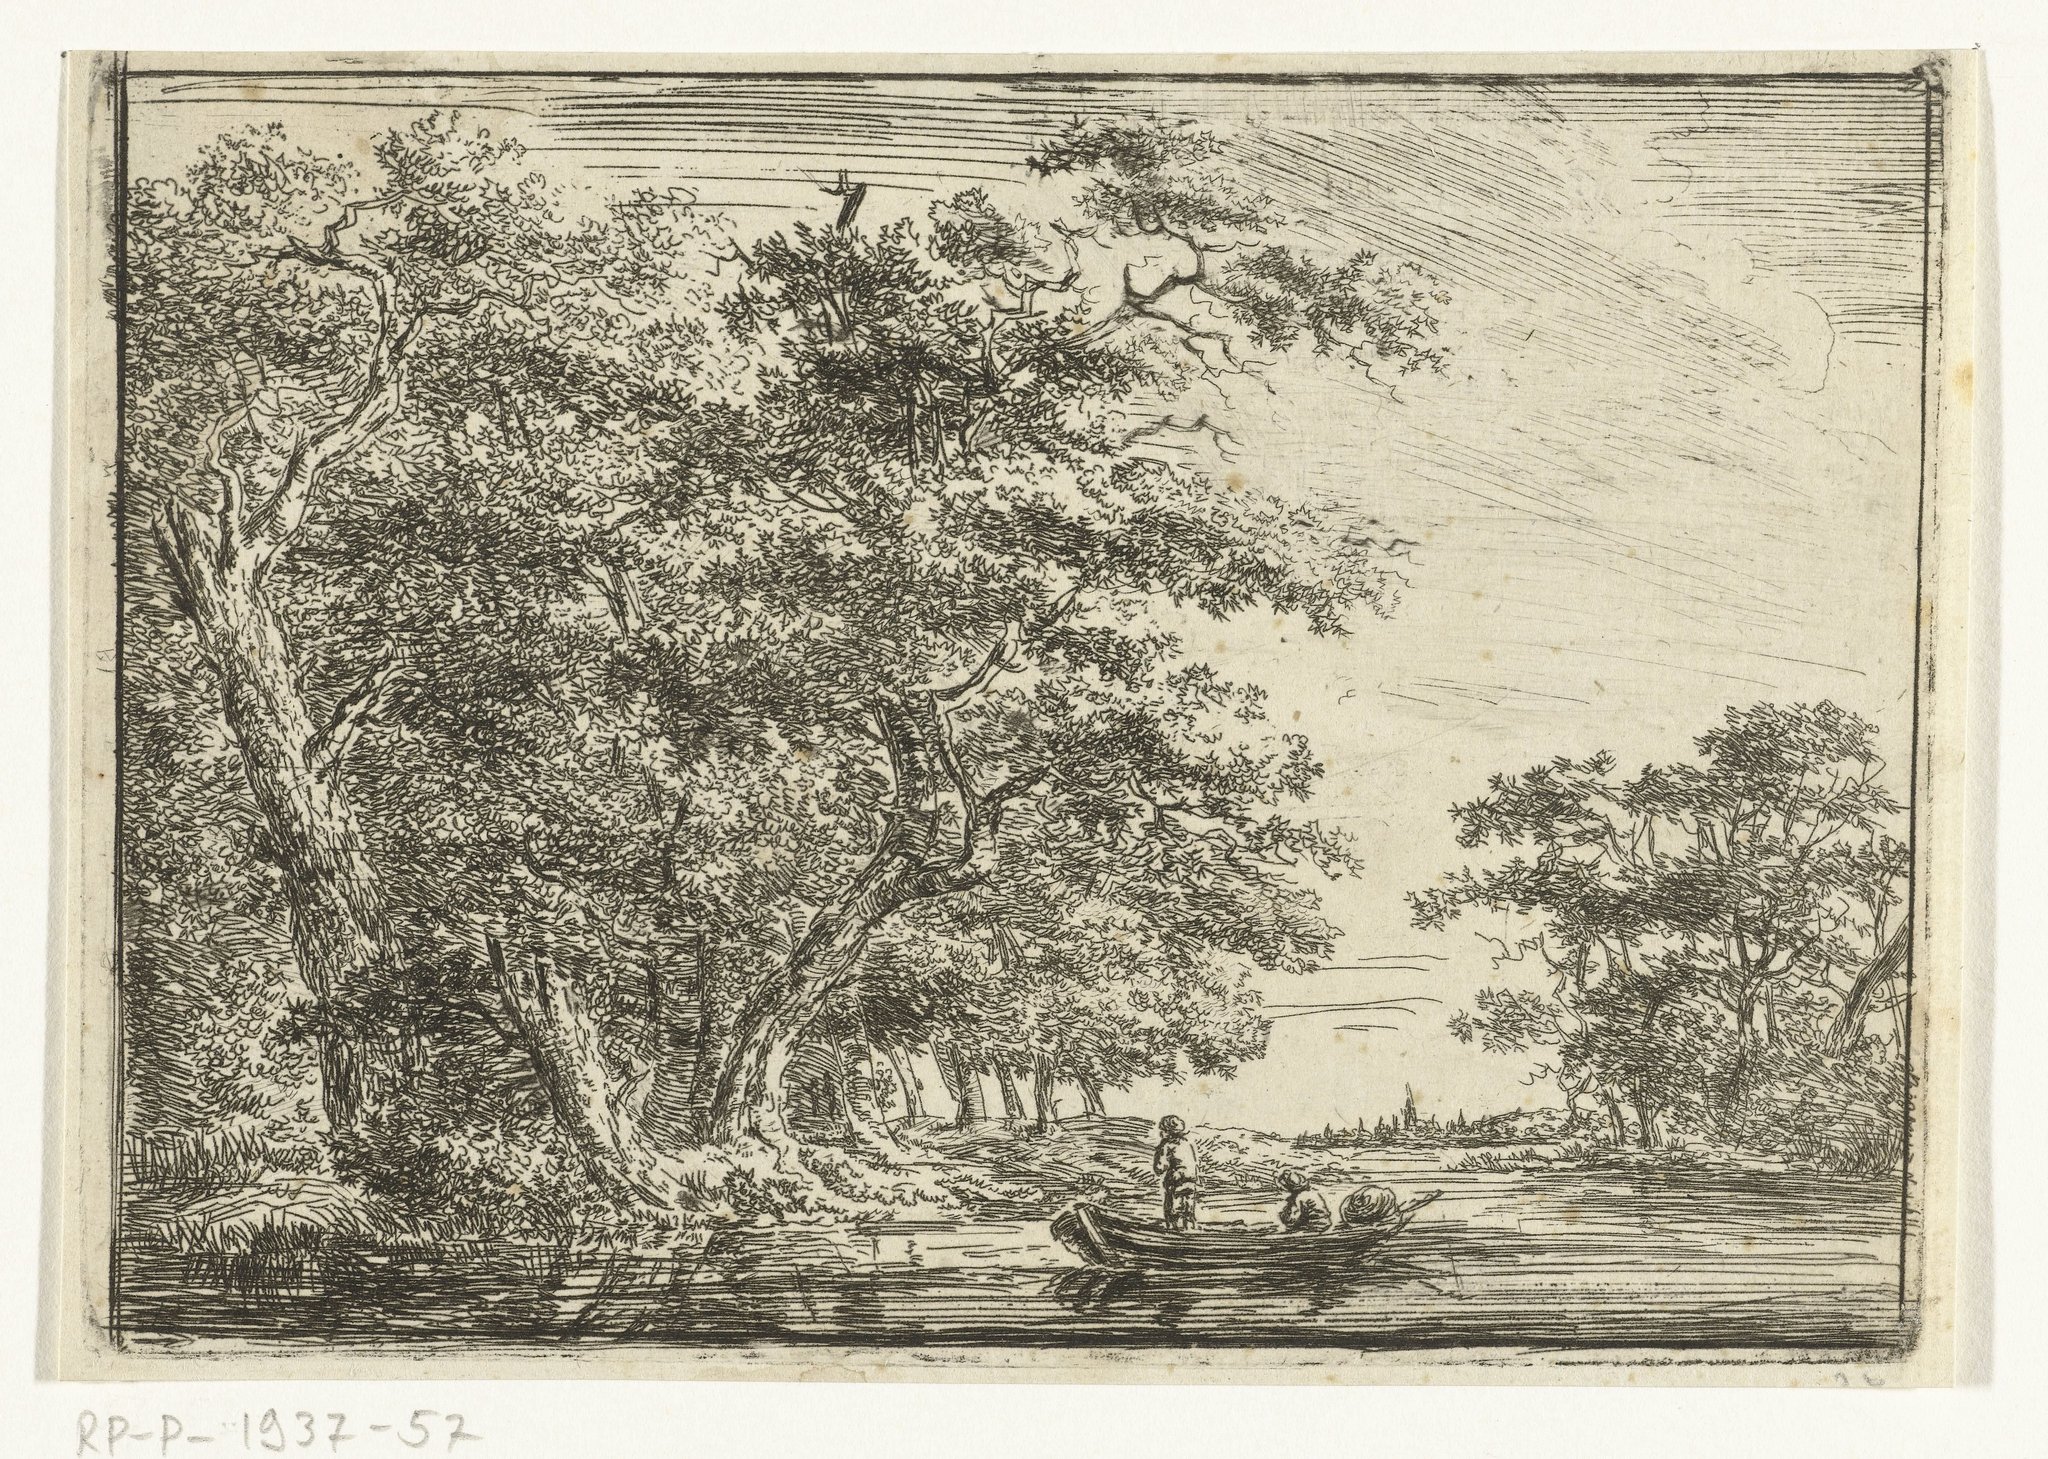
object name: print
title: Vissers in bootje aan bosrijke oever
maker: hermanus van brussel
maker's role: draughtsman, print maker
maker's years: 1763-1815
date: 1800-1815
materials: paper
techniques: drypoint, etching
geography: netherlands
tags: landscapes in the temperate zone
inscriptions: collector's mark: Lugt 2228, collector's mark: Lugt 2760